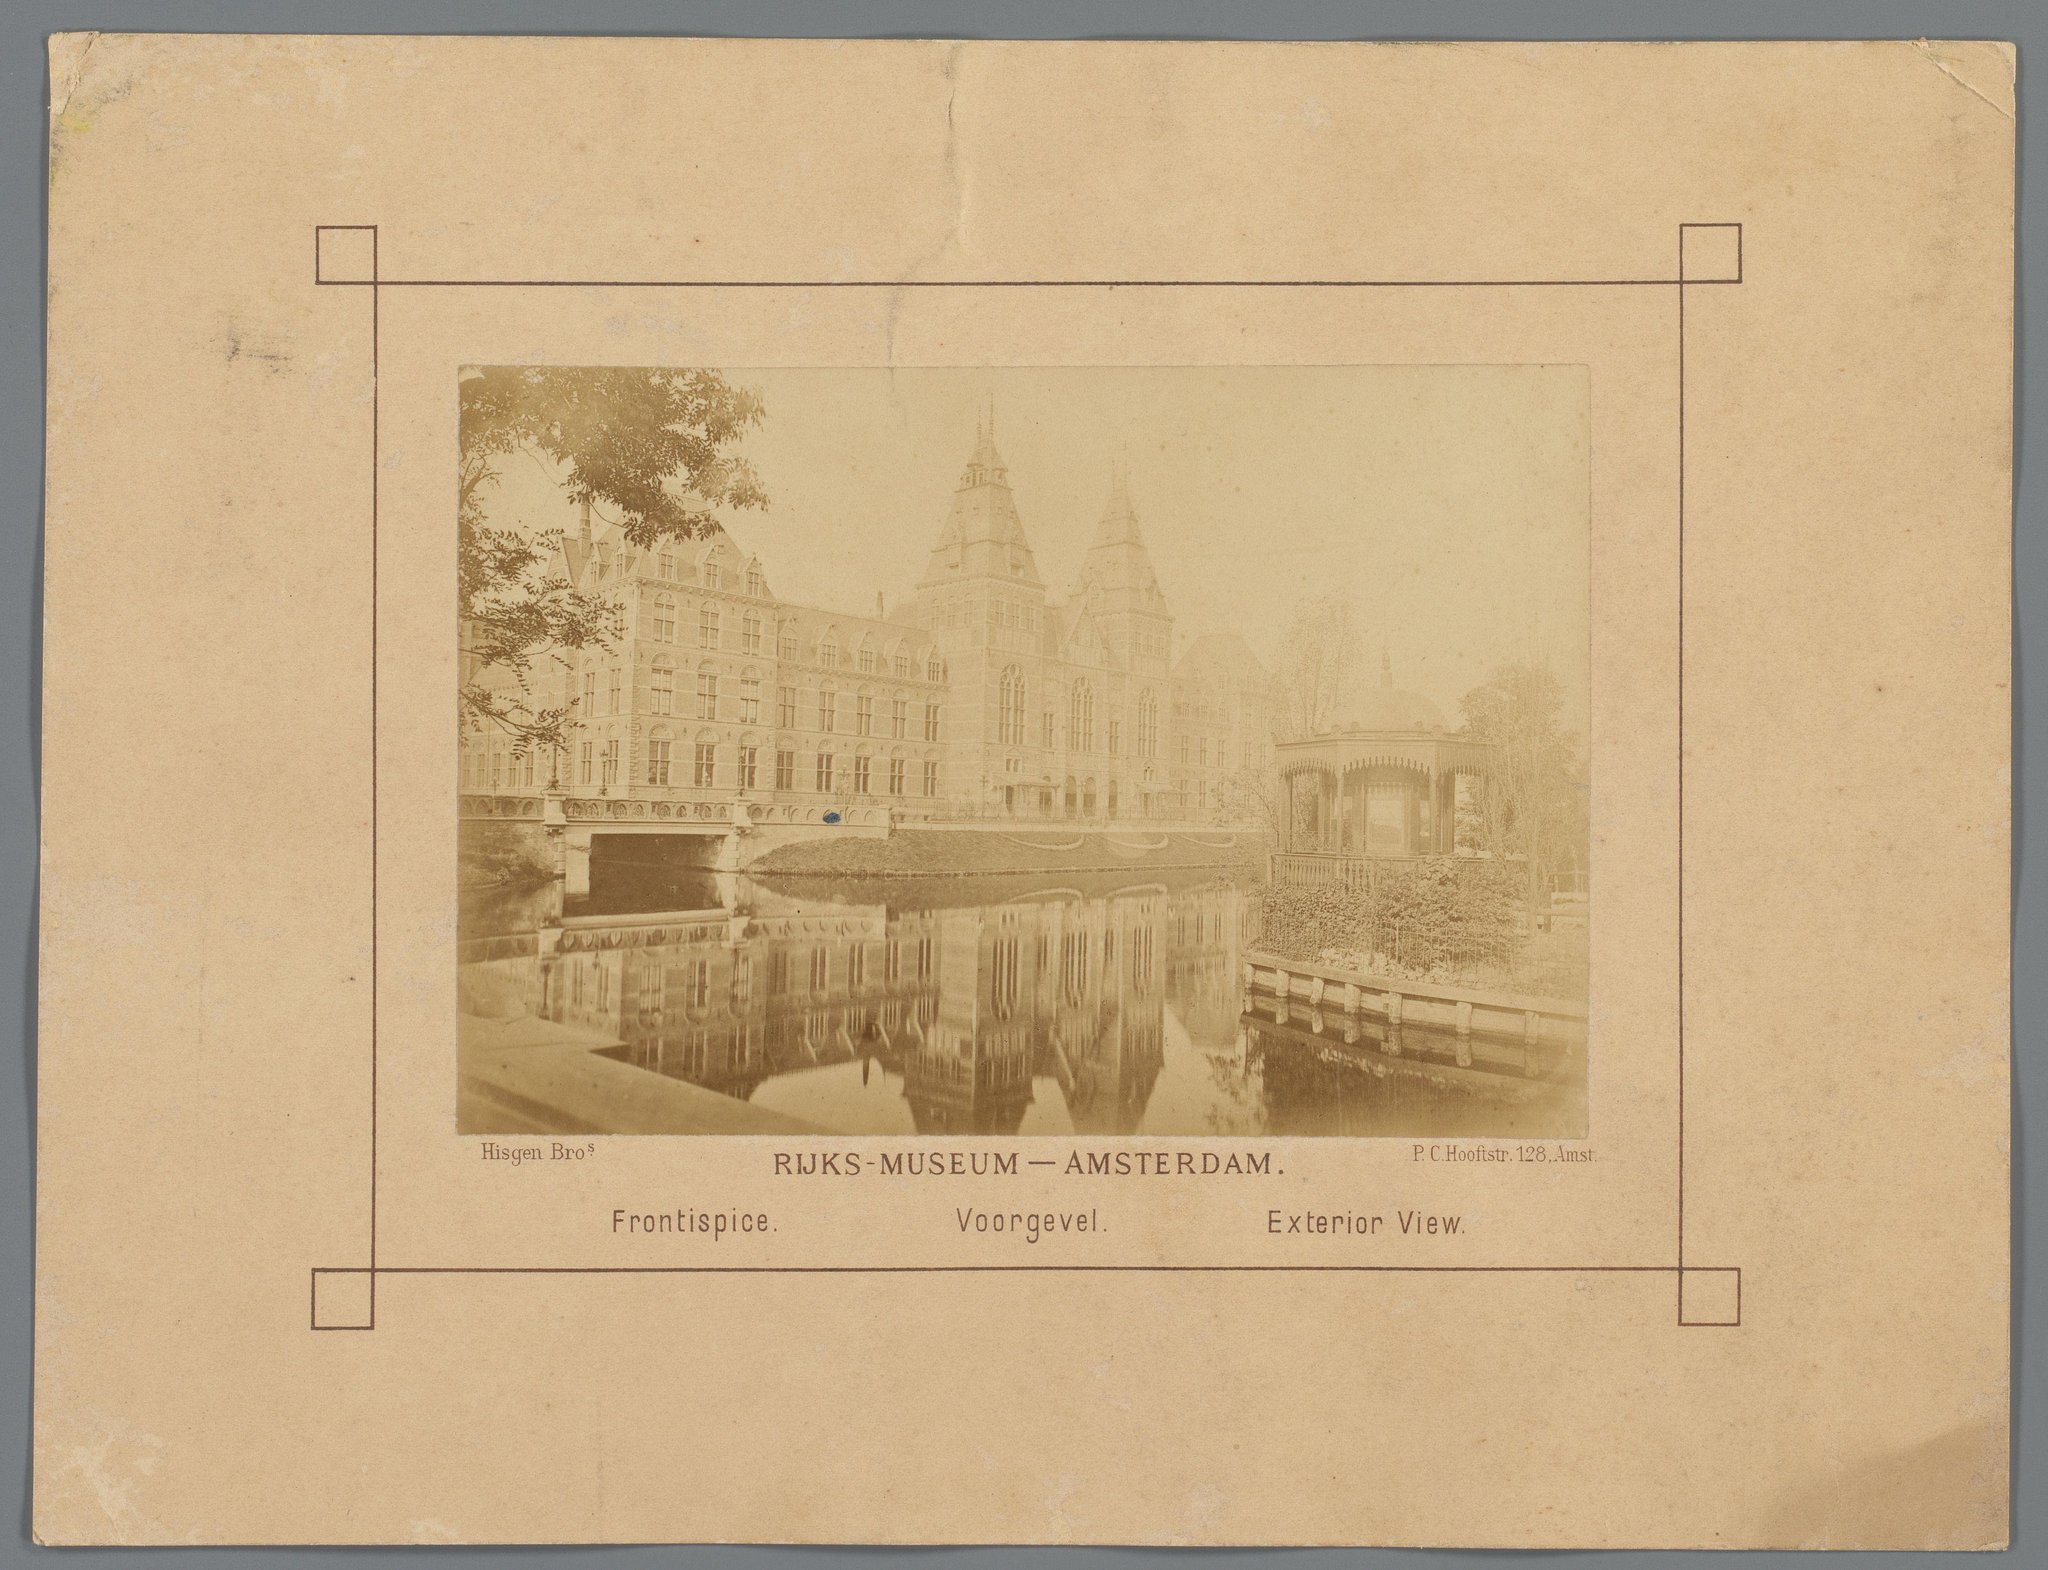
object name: photograph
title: Rijks-Museum - Amsterdam. Frontispice. Voorgevel. Exterior View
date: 1884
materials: cardboard, paper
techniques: albumen print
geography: amsterdam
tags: canals, waters (in city), permanent exhibition, museum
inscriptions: inscription: ‘P.C. Hooftstr. 128, Amst.’